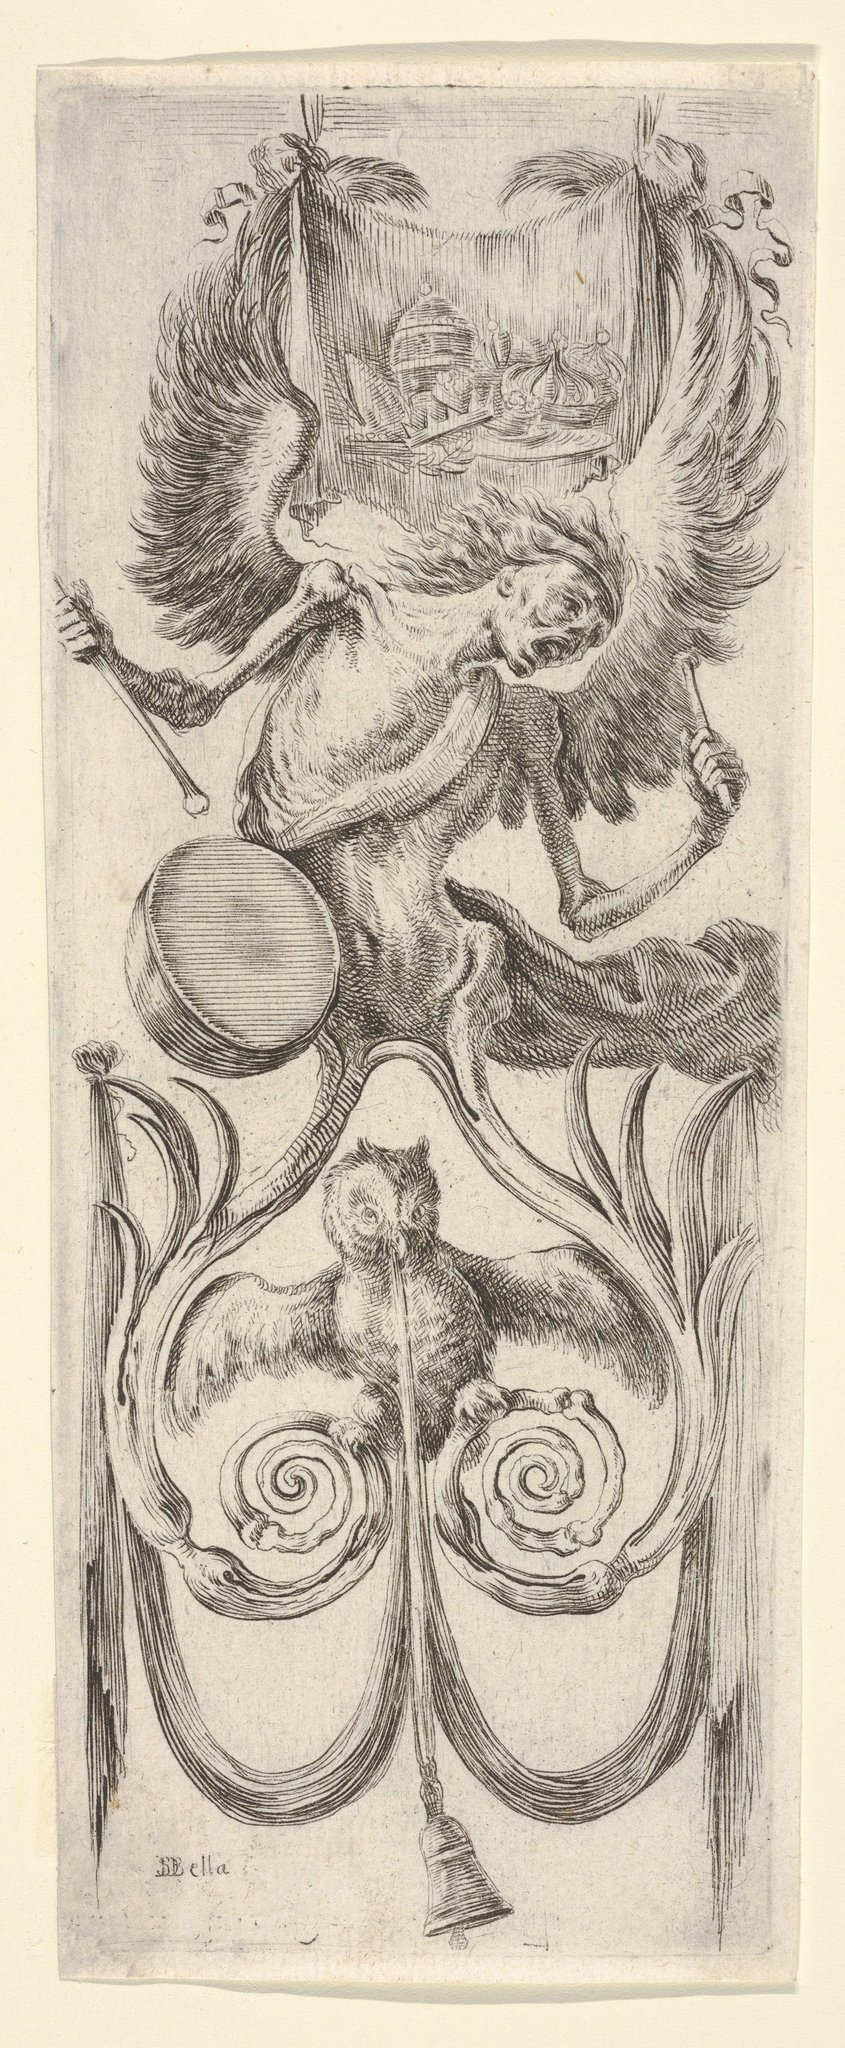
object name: print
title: Death beating a drum above, an owl and a bell attached to a ribbon below, from "Ornaments or Grotesques" (Ornamenti o Grottesche)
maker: stefano della bella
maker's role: artist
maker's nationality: italian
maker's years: 1610-1664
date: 1650-1656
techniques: etching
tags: musical instruments,drums,owls